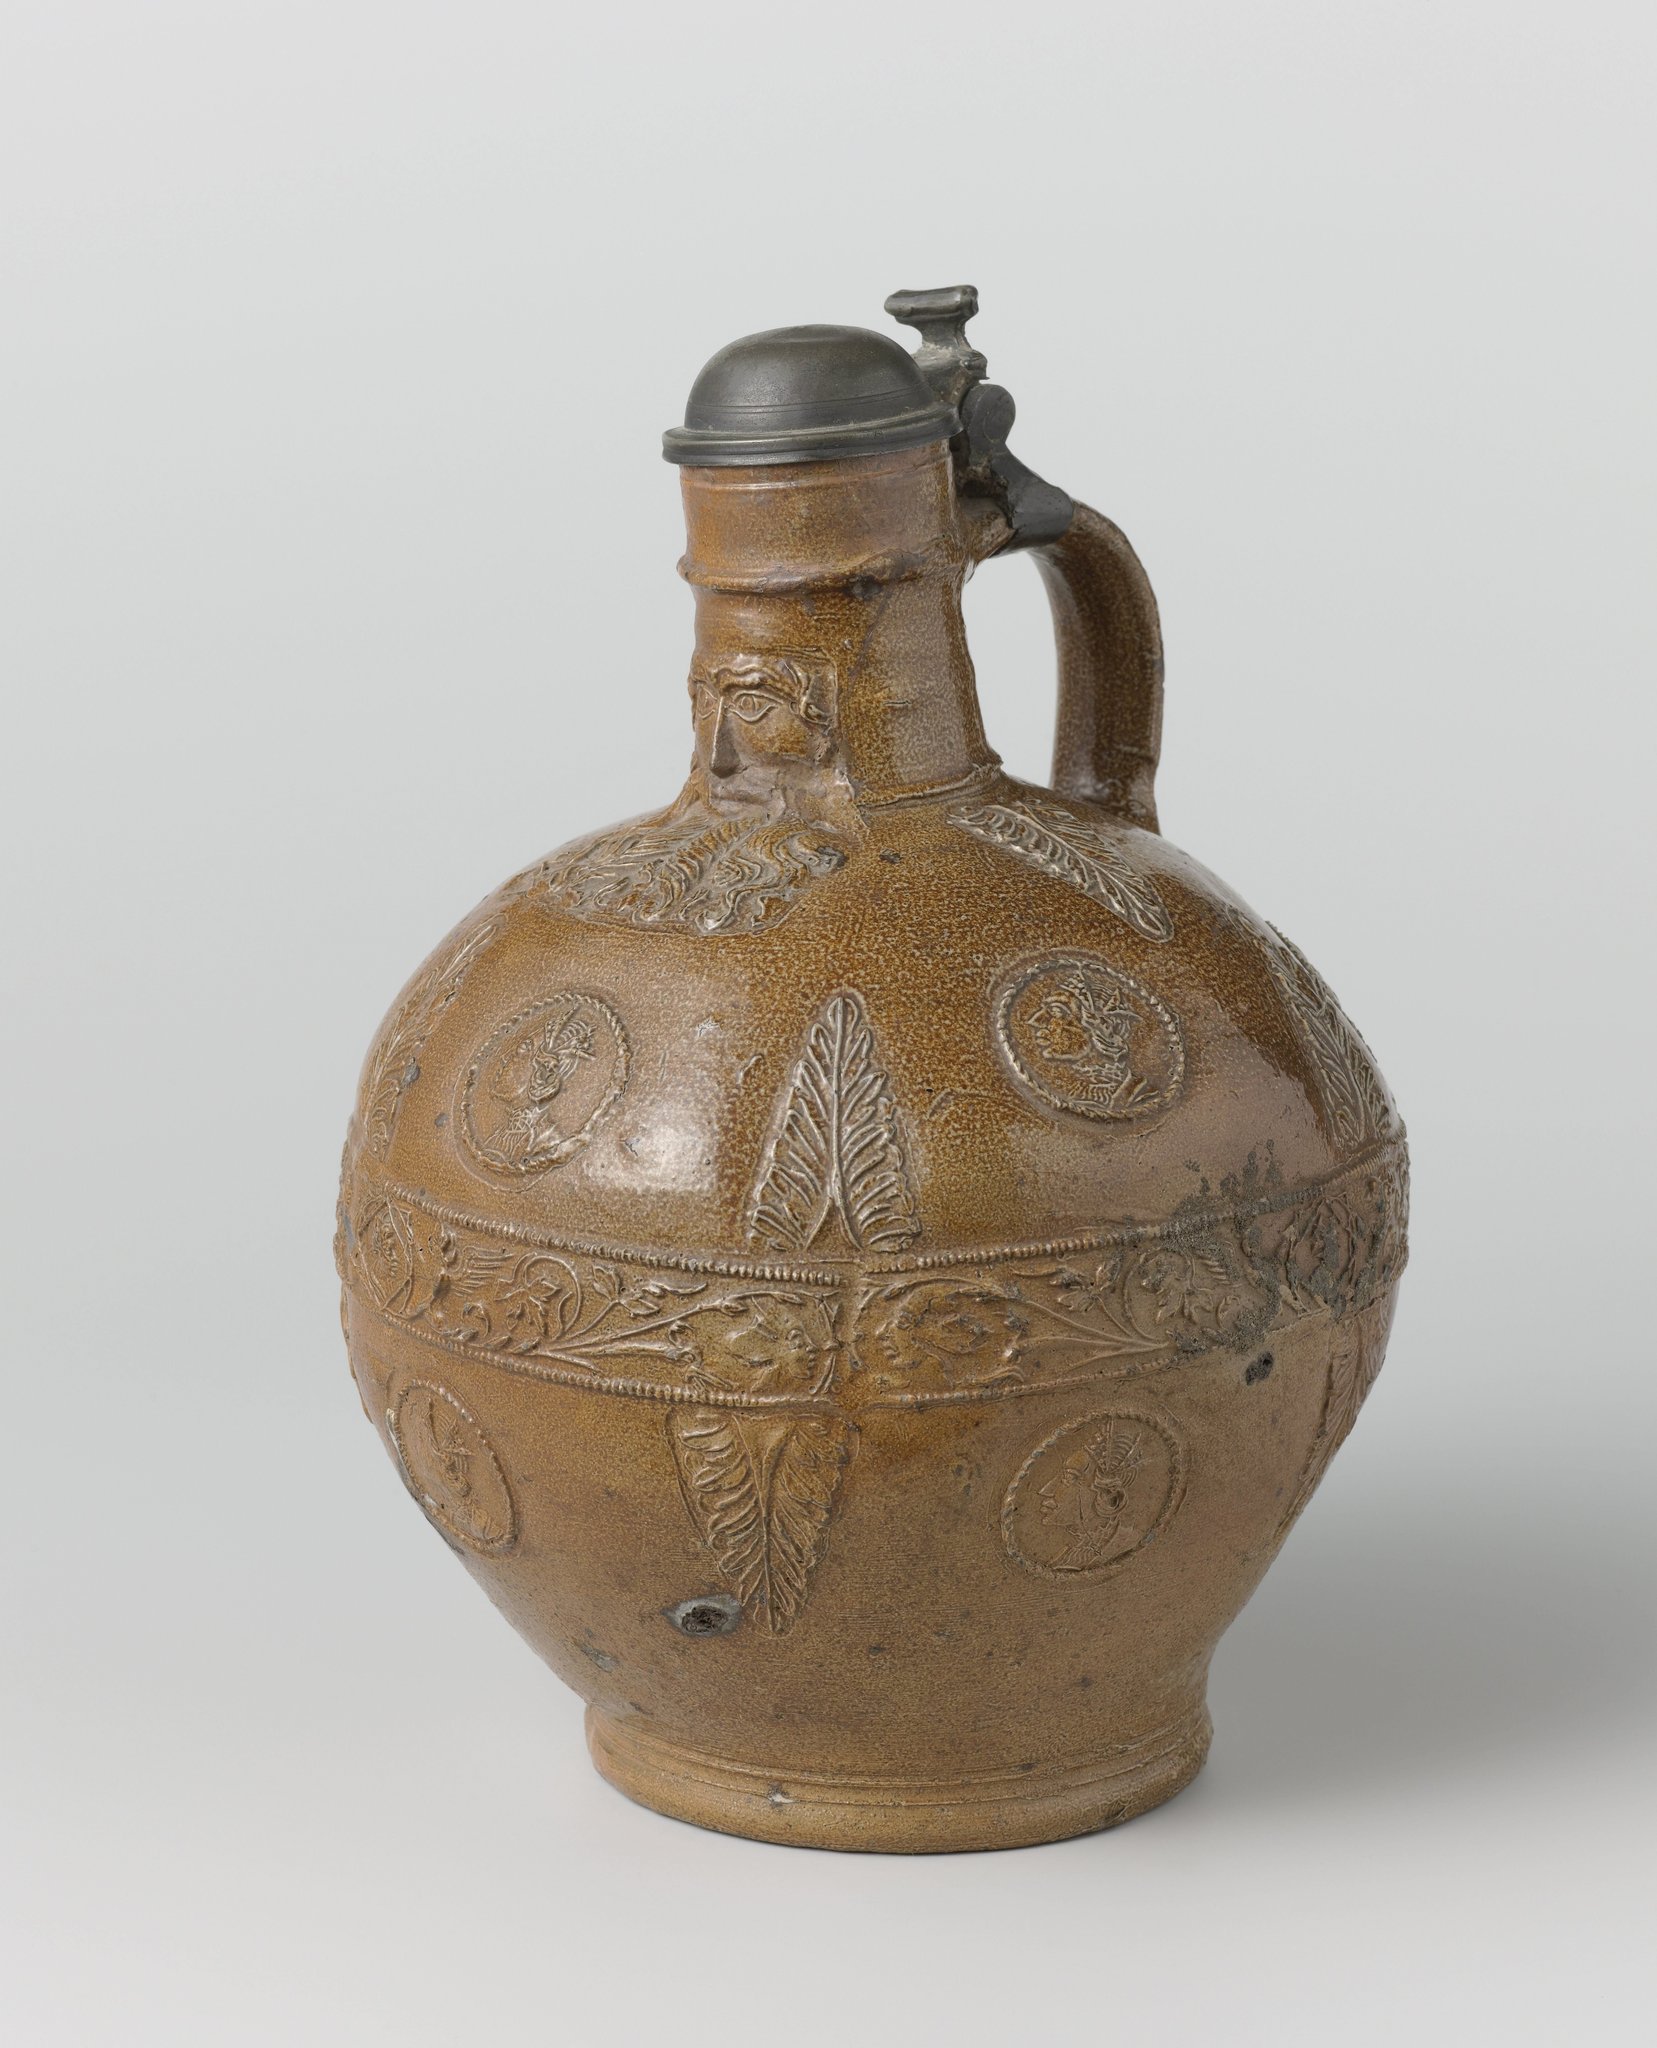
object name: jug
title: Bartmann (bearded-man) jug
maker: Anonymous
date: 1550-1599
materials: engobe, glaze, stoneware, tin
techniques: firing, forming, relief, turning, vitrification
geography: frechen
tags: foliage ~ ornament, beard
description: Kruik (baardmankruik) van steengoed op hoge voet met een bolvormig lichaam en smalle nek. Het C-vormige oor is bevestigd aan de nek en de schouder. Profielen op de nek en voet. Bedekt met een bruine engobe. Op de buik in reliëf een gedrukte en opgelegde decoratieve band met bloemranken. Aan weerszijden van het opschrift medaillons met portretten en profil en bladmotieven. Op de nek, doorlopend op de schouder, een baardman. Bevestigd aan het oor een tinnen montuur met deksel. Frechen.